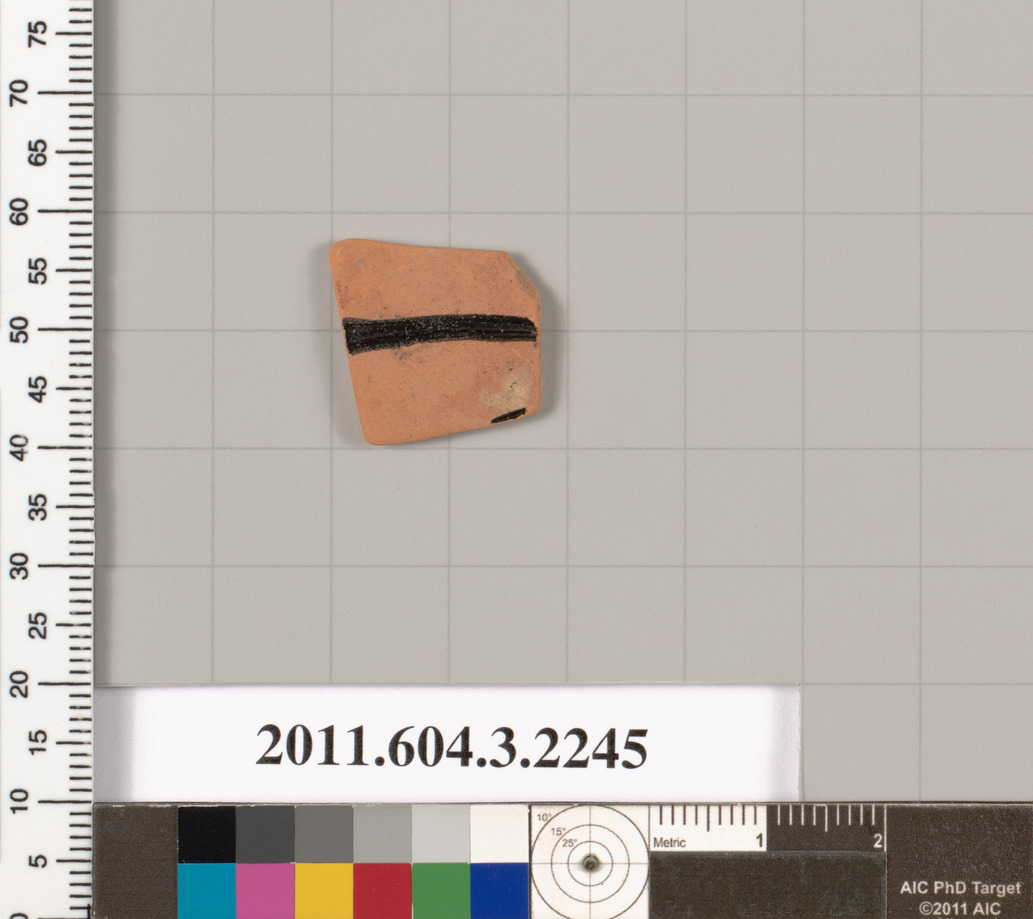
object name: kylix fragment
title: Terracotta fragment of a kylix (drinking cup)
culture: greek, attic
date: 600-401 BCE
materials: terracotta